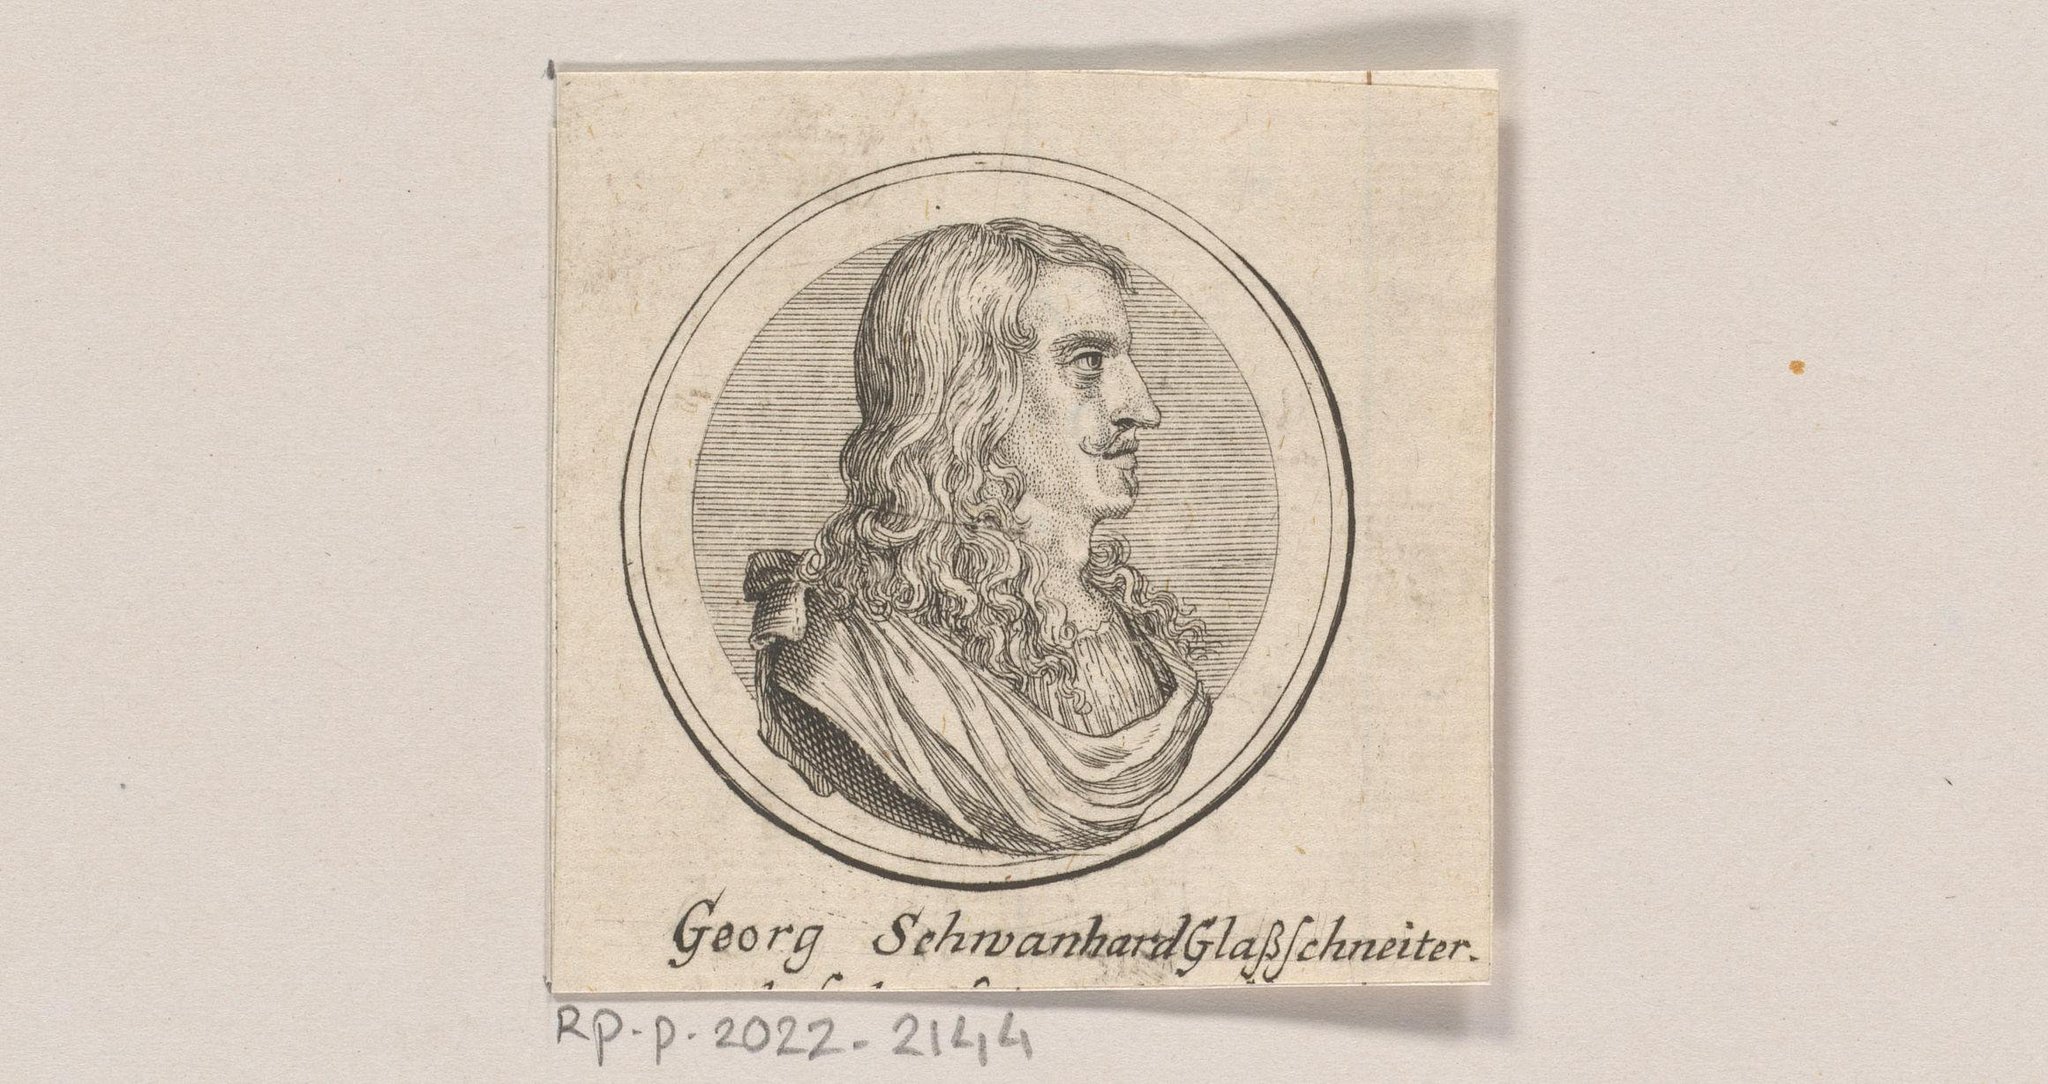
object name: print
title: Portret van Georg Schwanhard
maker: Anonymous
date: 1631-1750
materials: paper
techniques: etching, snipping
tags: engraver, etcher, other handicrafts ~ glass, historical persons